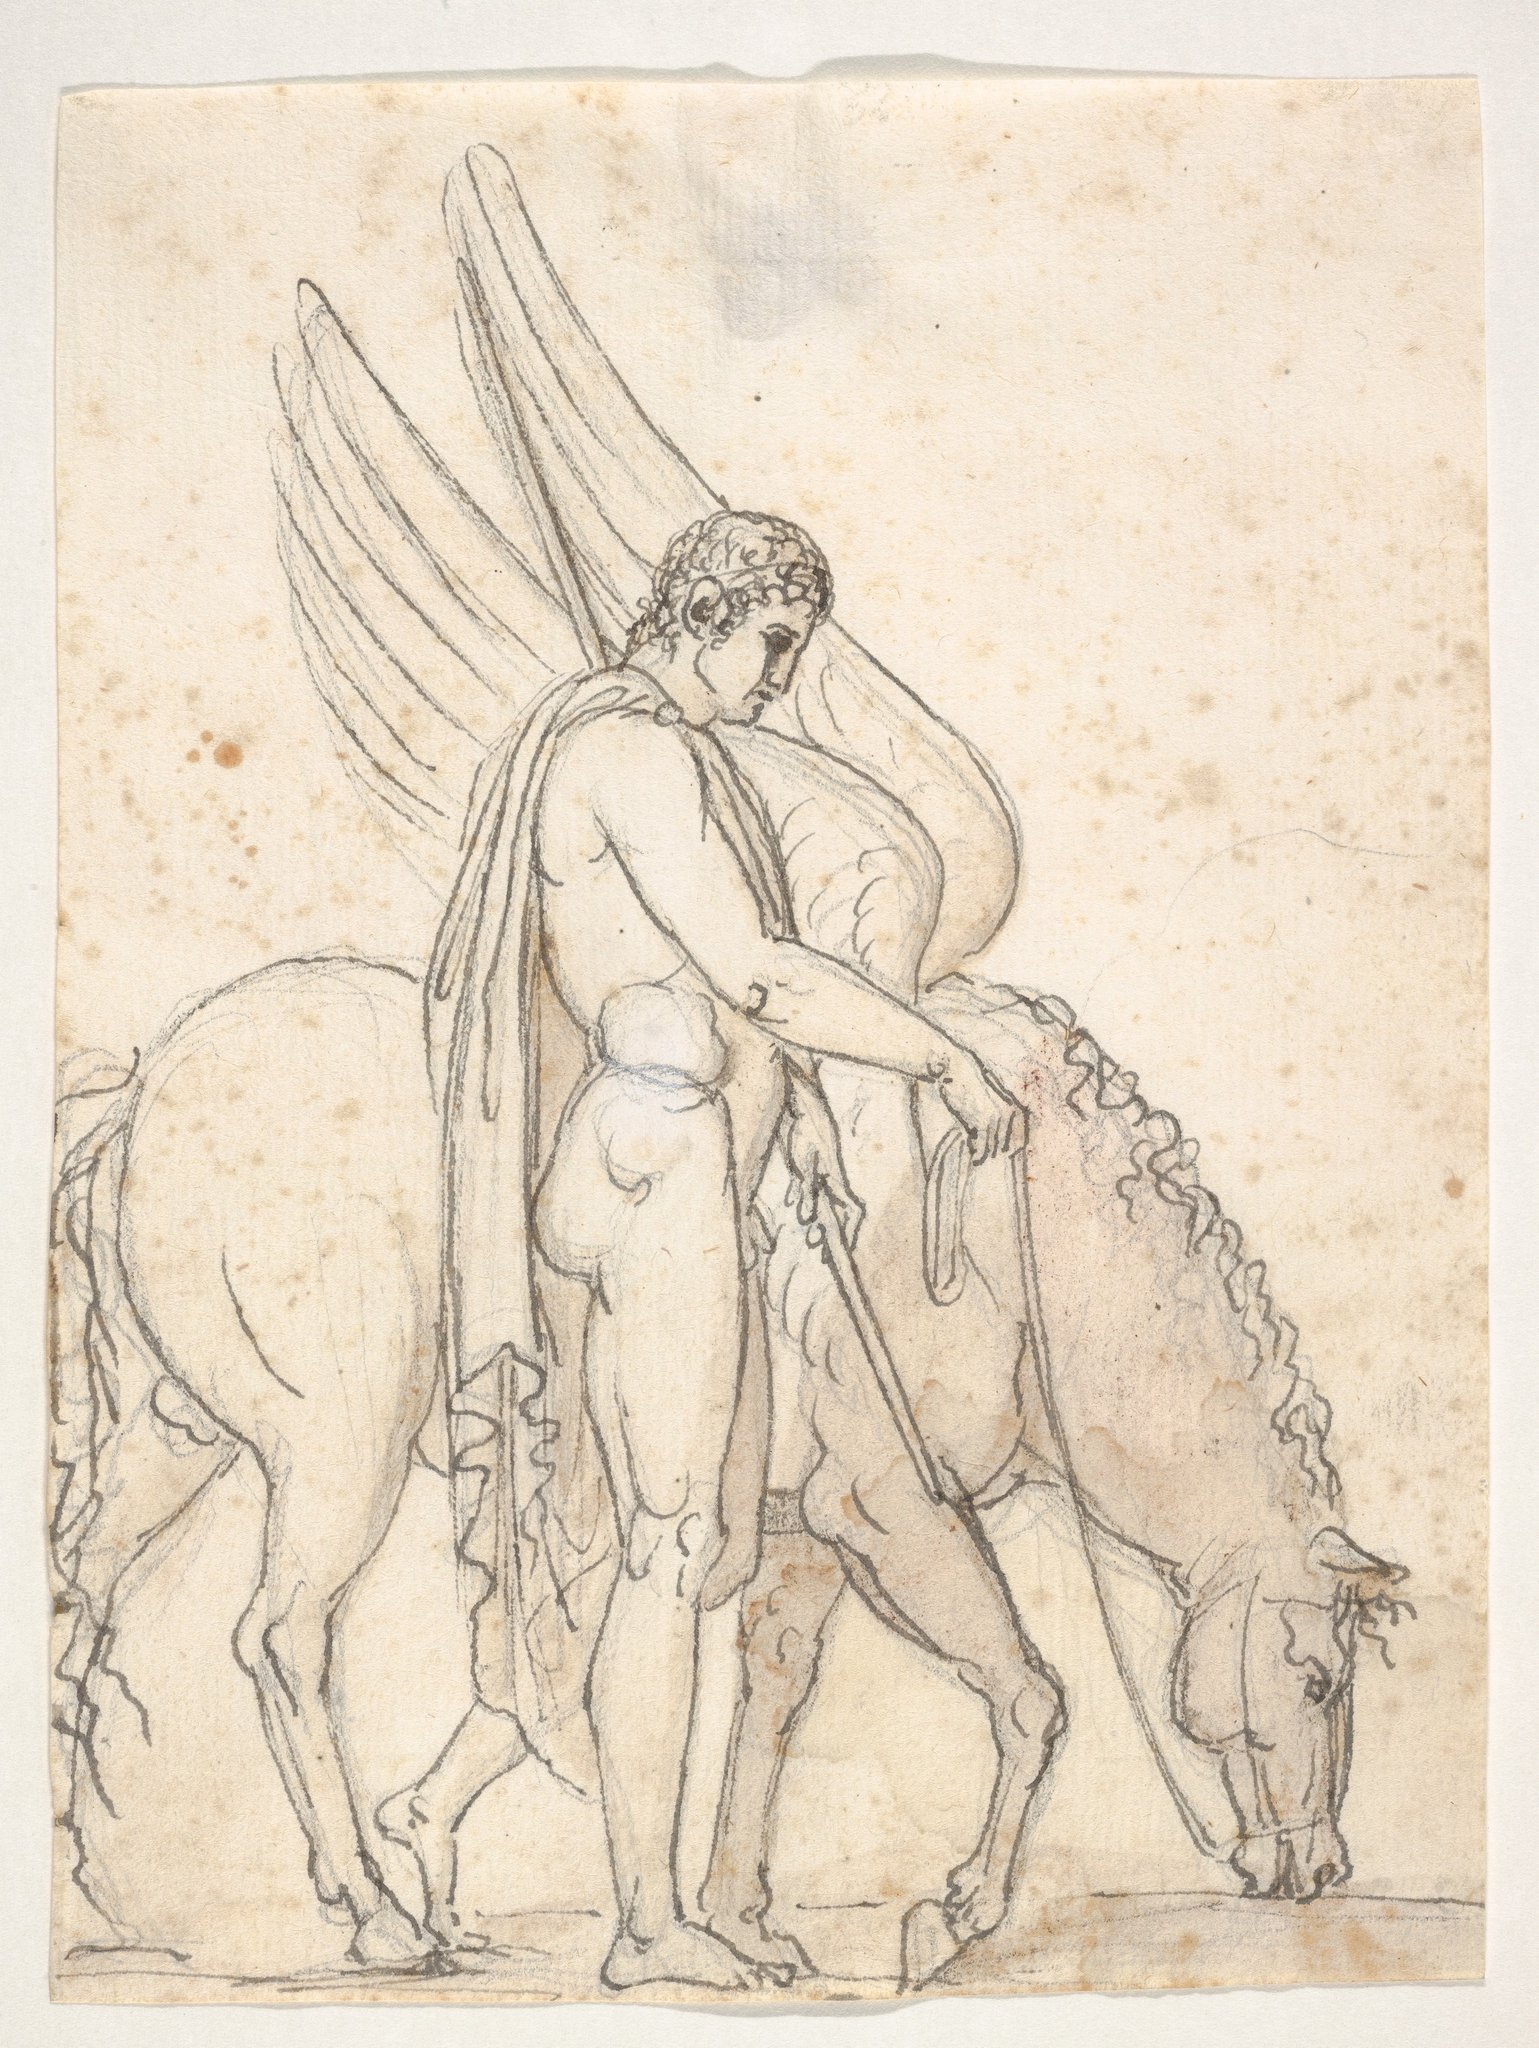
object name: drawing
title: Bellerophon and Pegasus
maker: bertel thorvaldsen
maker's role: artist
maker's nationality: danish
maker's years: 1770-1844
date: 1790-1844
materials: chalk, graphite, ink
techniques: pen, wash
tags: male nudes,pegasus